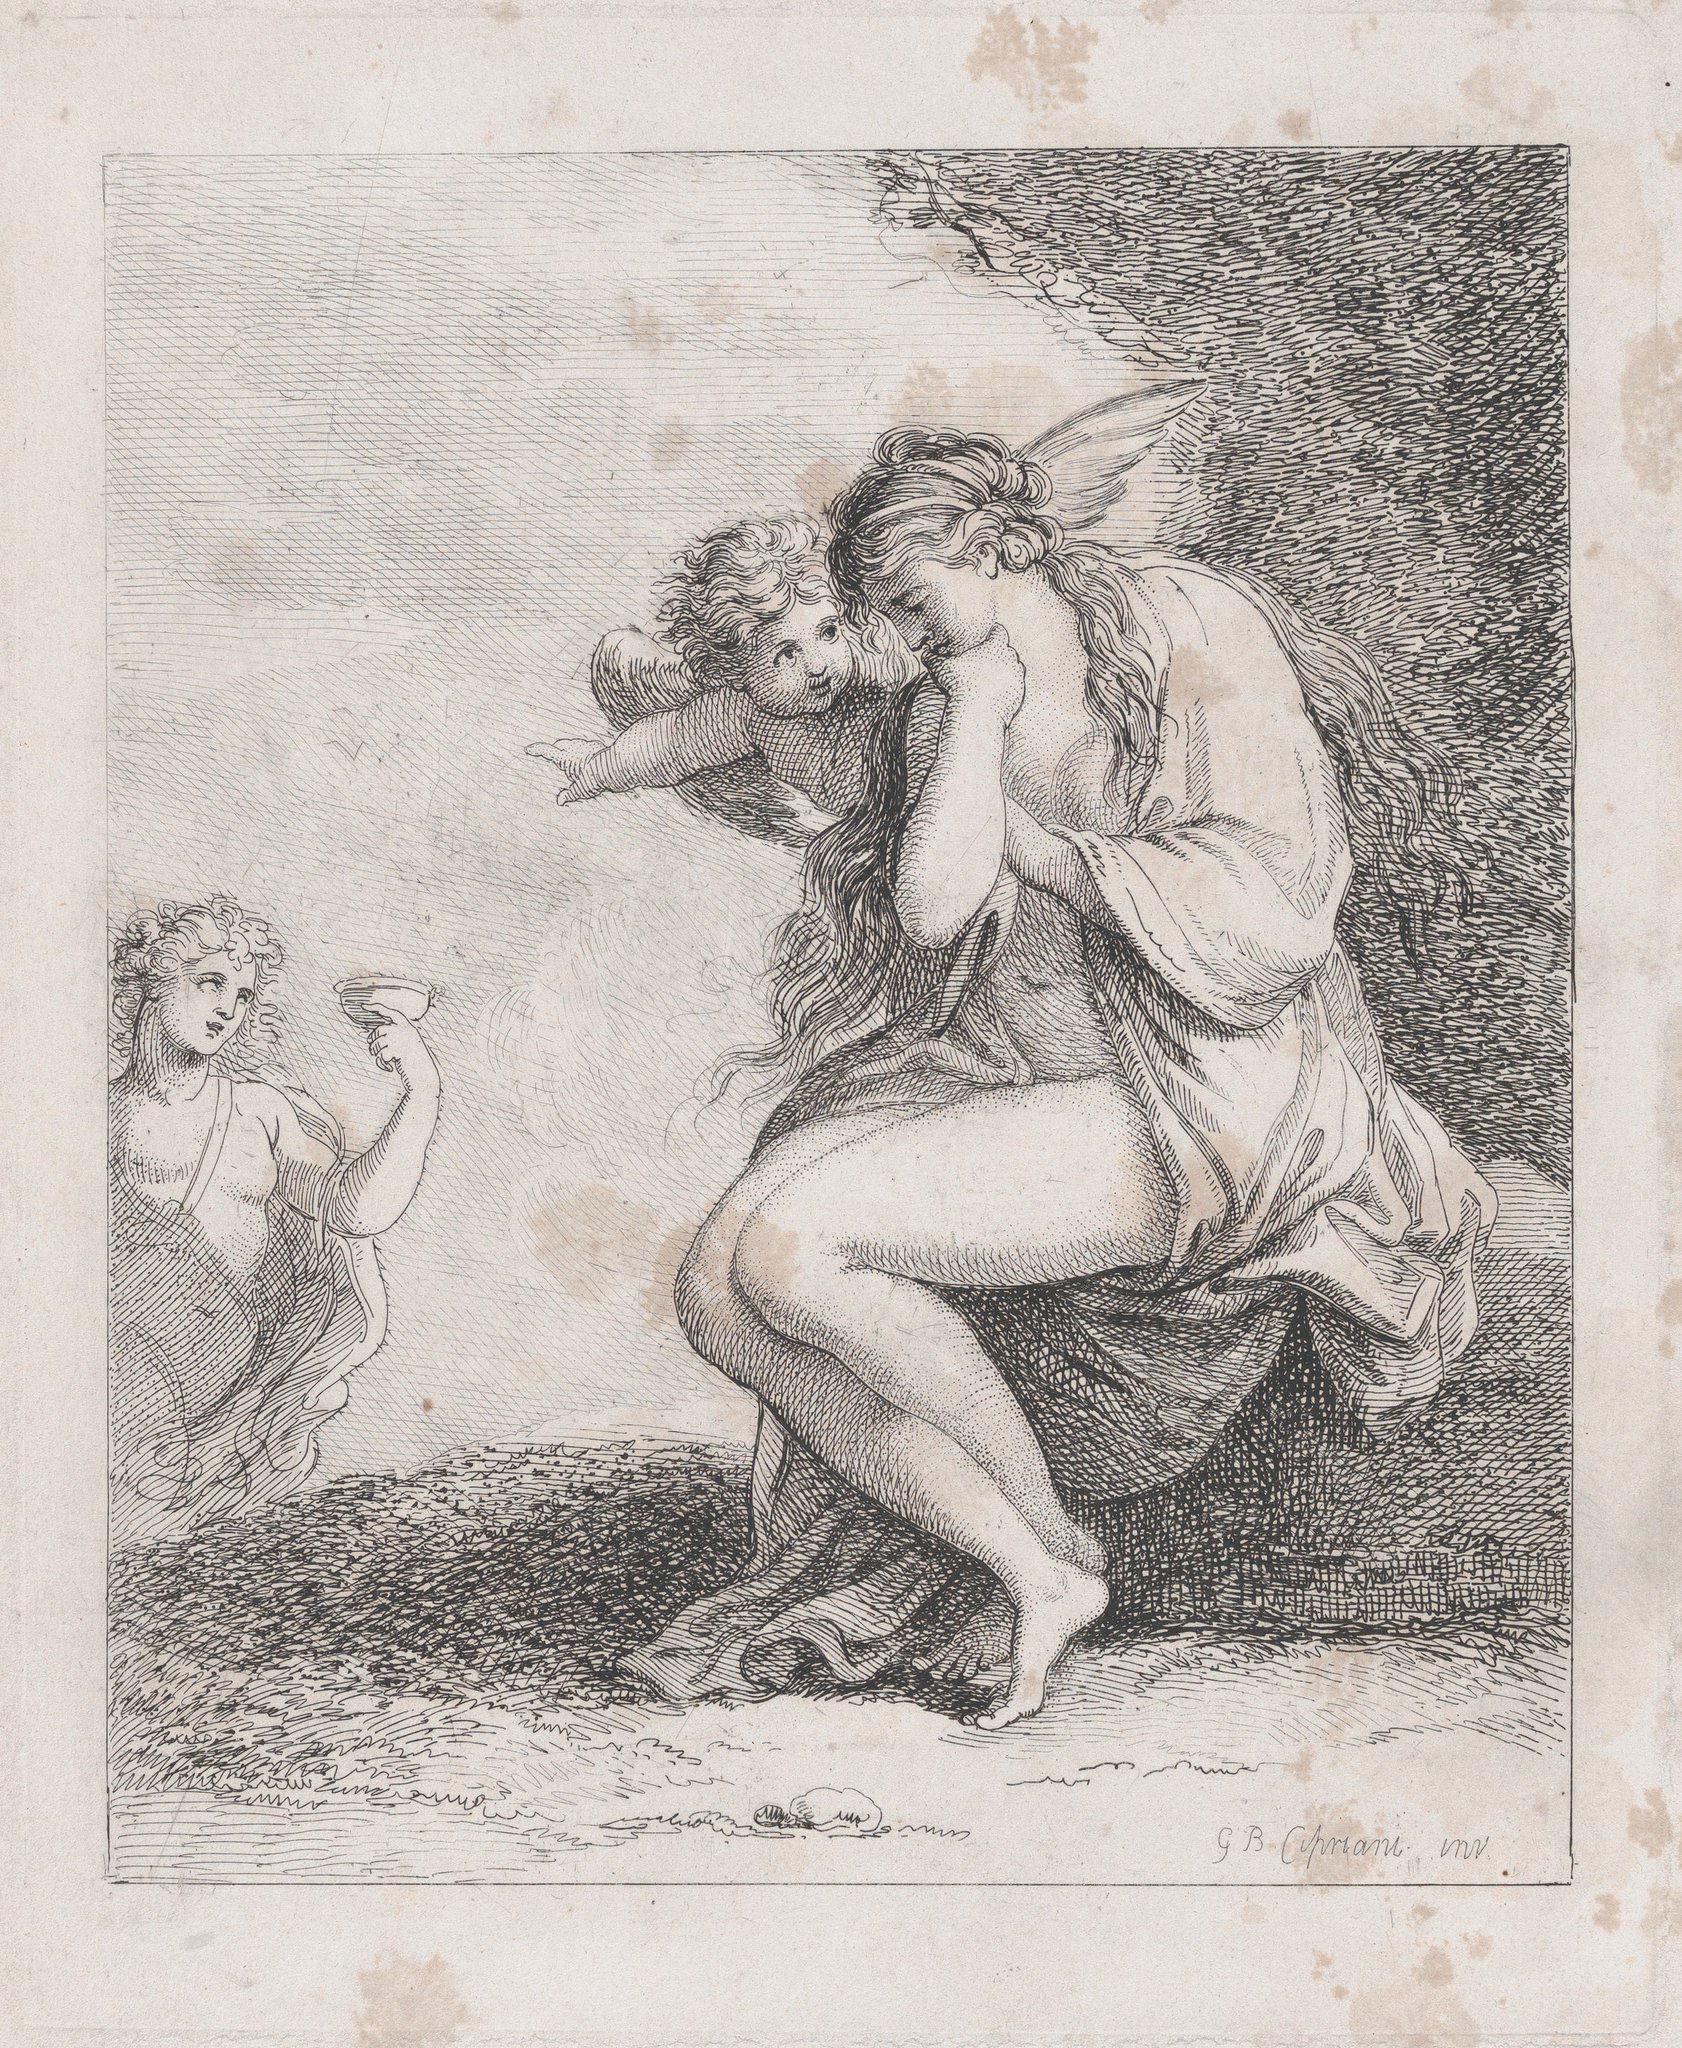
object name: print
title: Ariadne on Naxos Approached by Bacchus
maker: thomas rowlandson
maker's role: artist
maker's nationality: british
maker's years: 1757-1827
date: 1790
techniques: etching